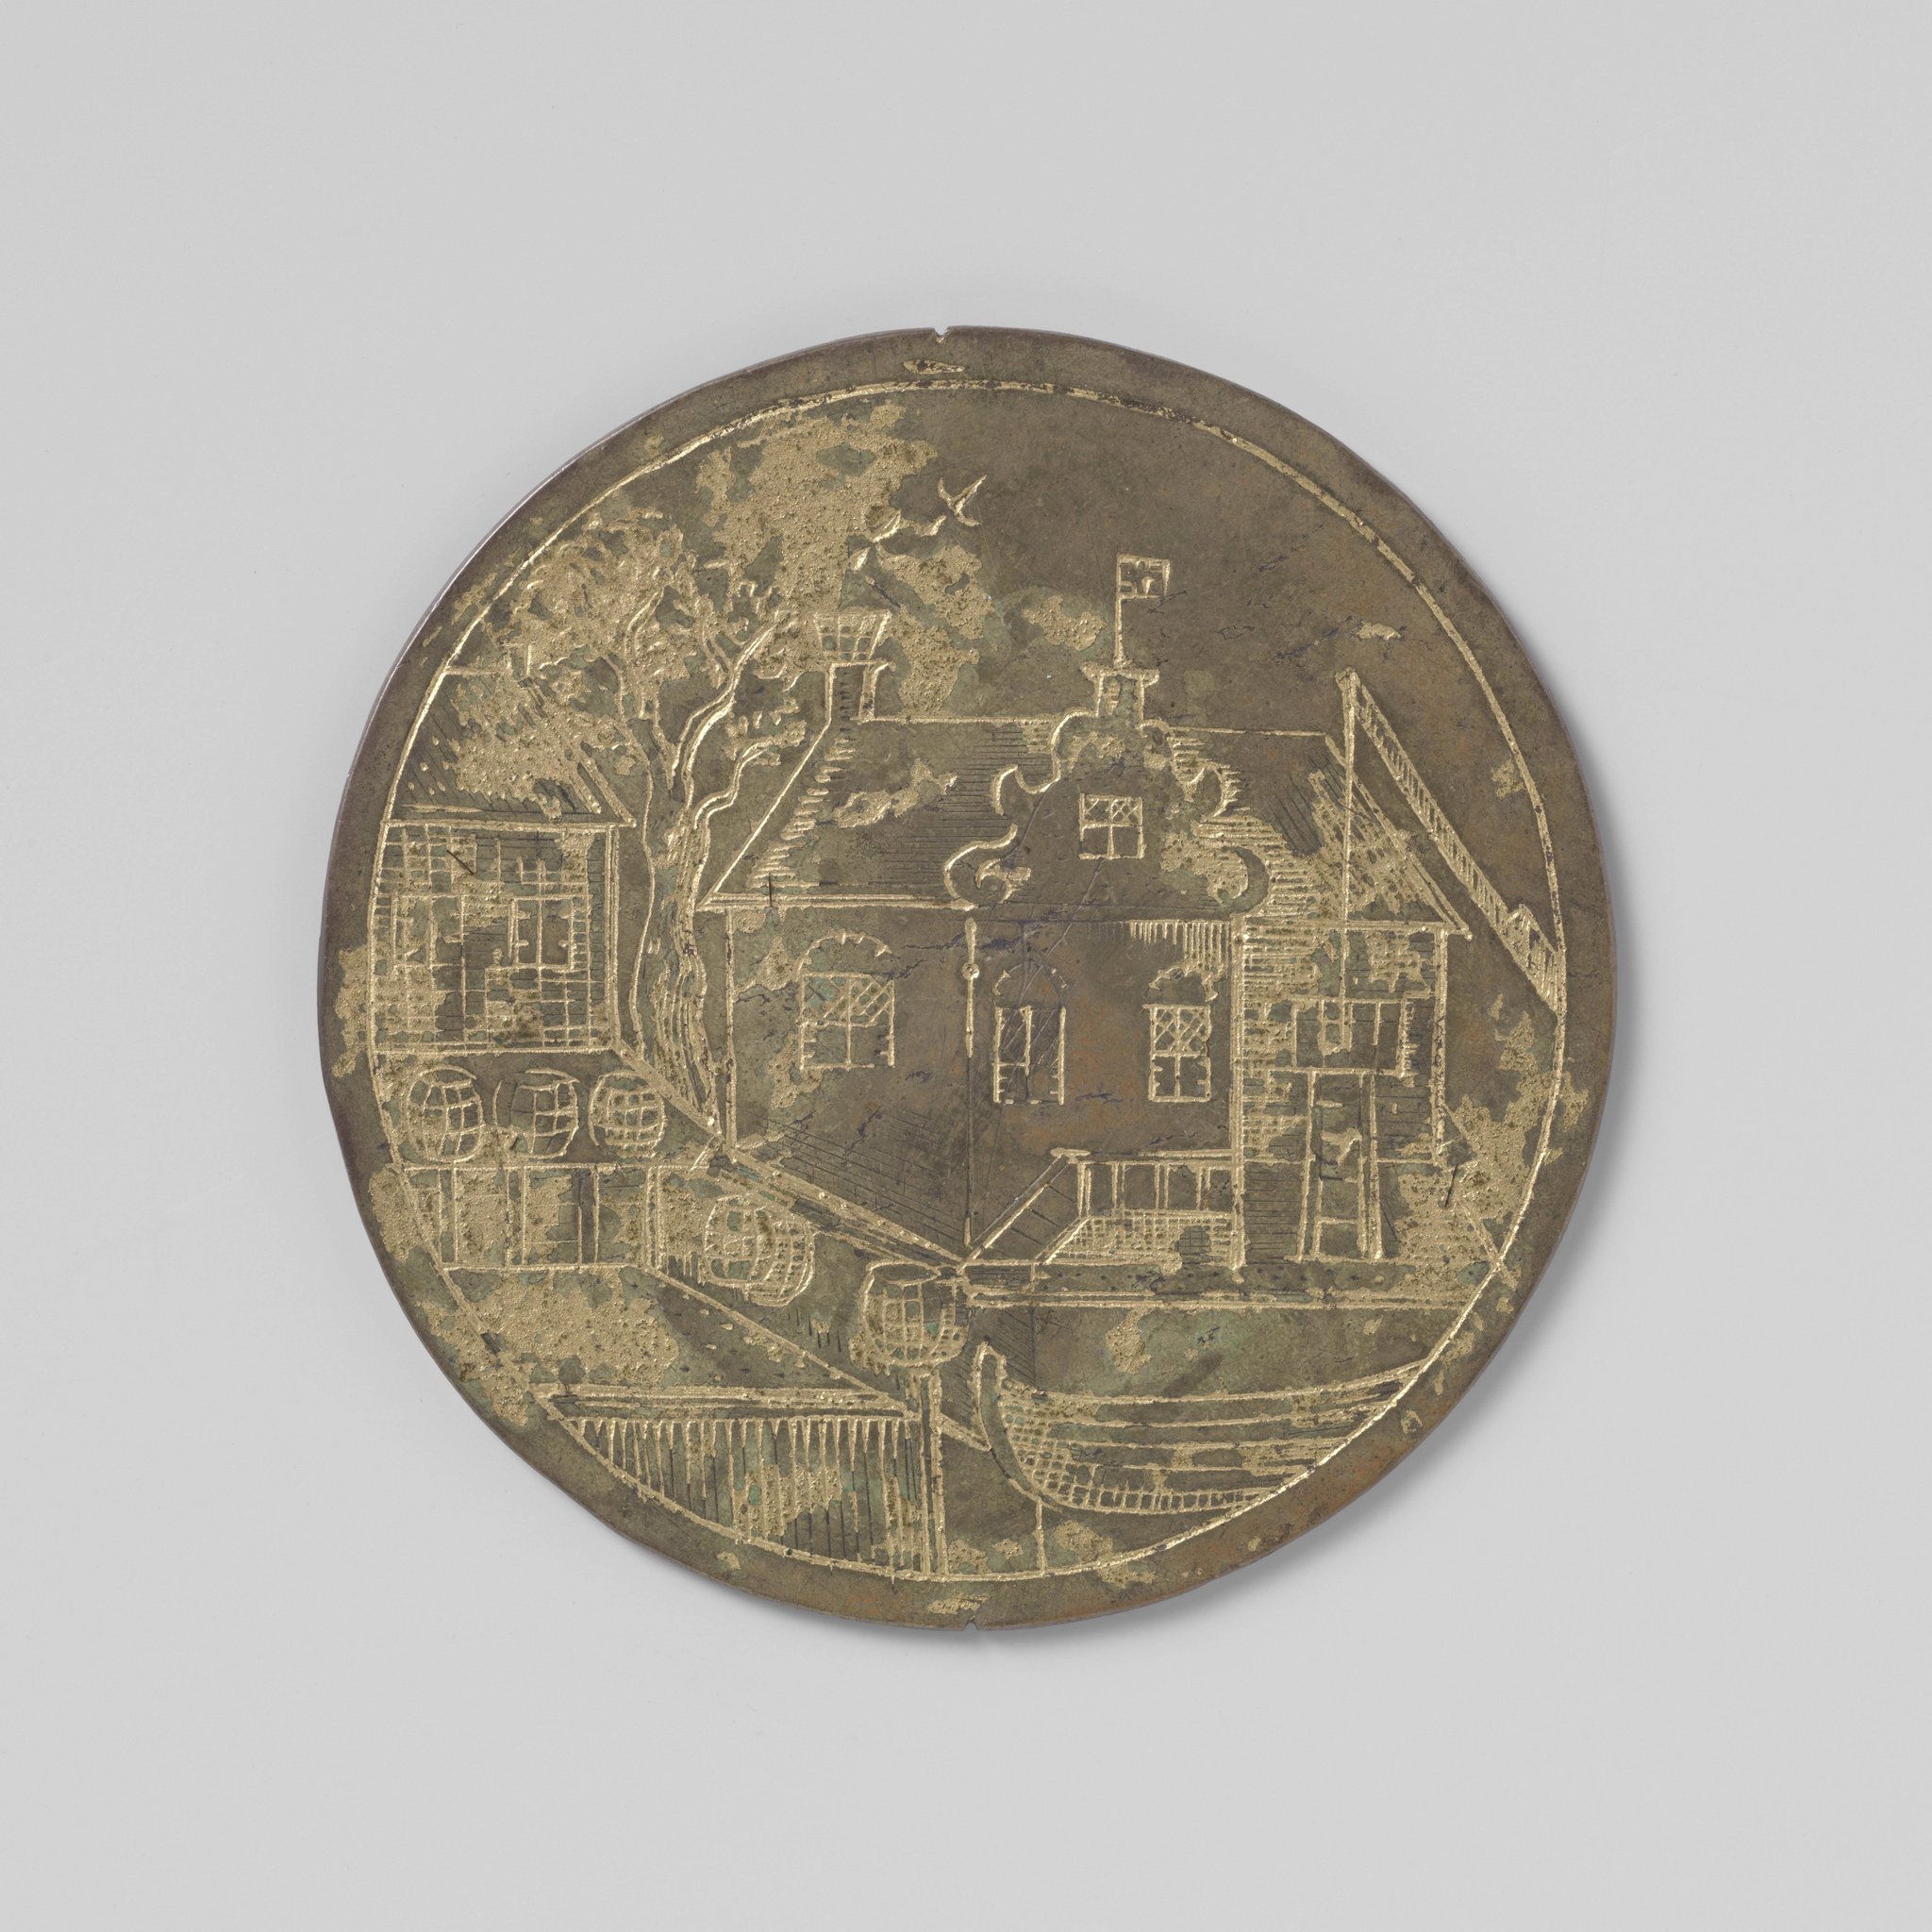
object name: adrespenning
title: Pietter Douwes, brouwer in Stavoren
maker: Anonymous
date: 1648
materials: brass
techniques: engraving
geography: stavoren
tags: pietter douwes, stavoren